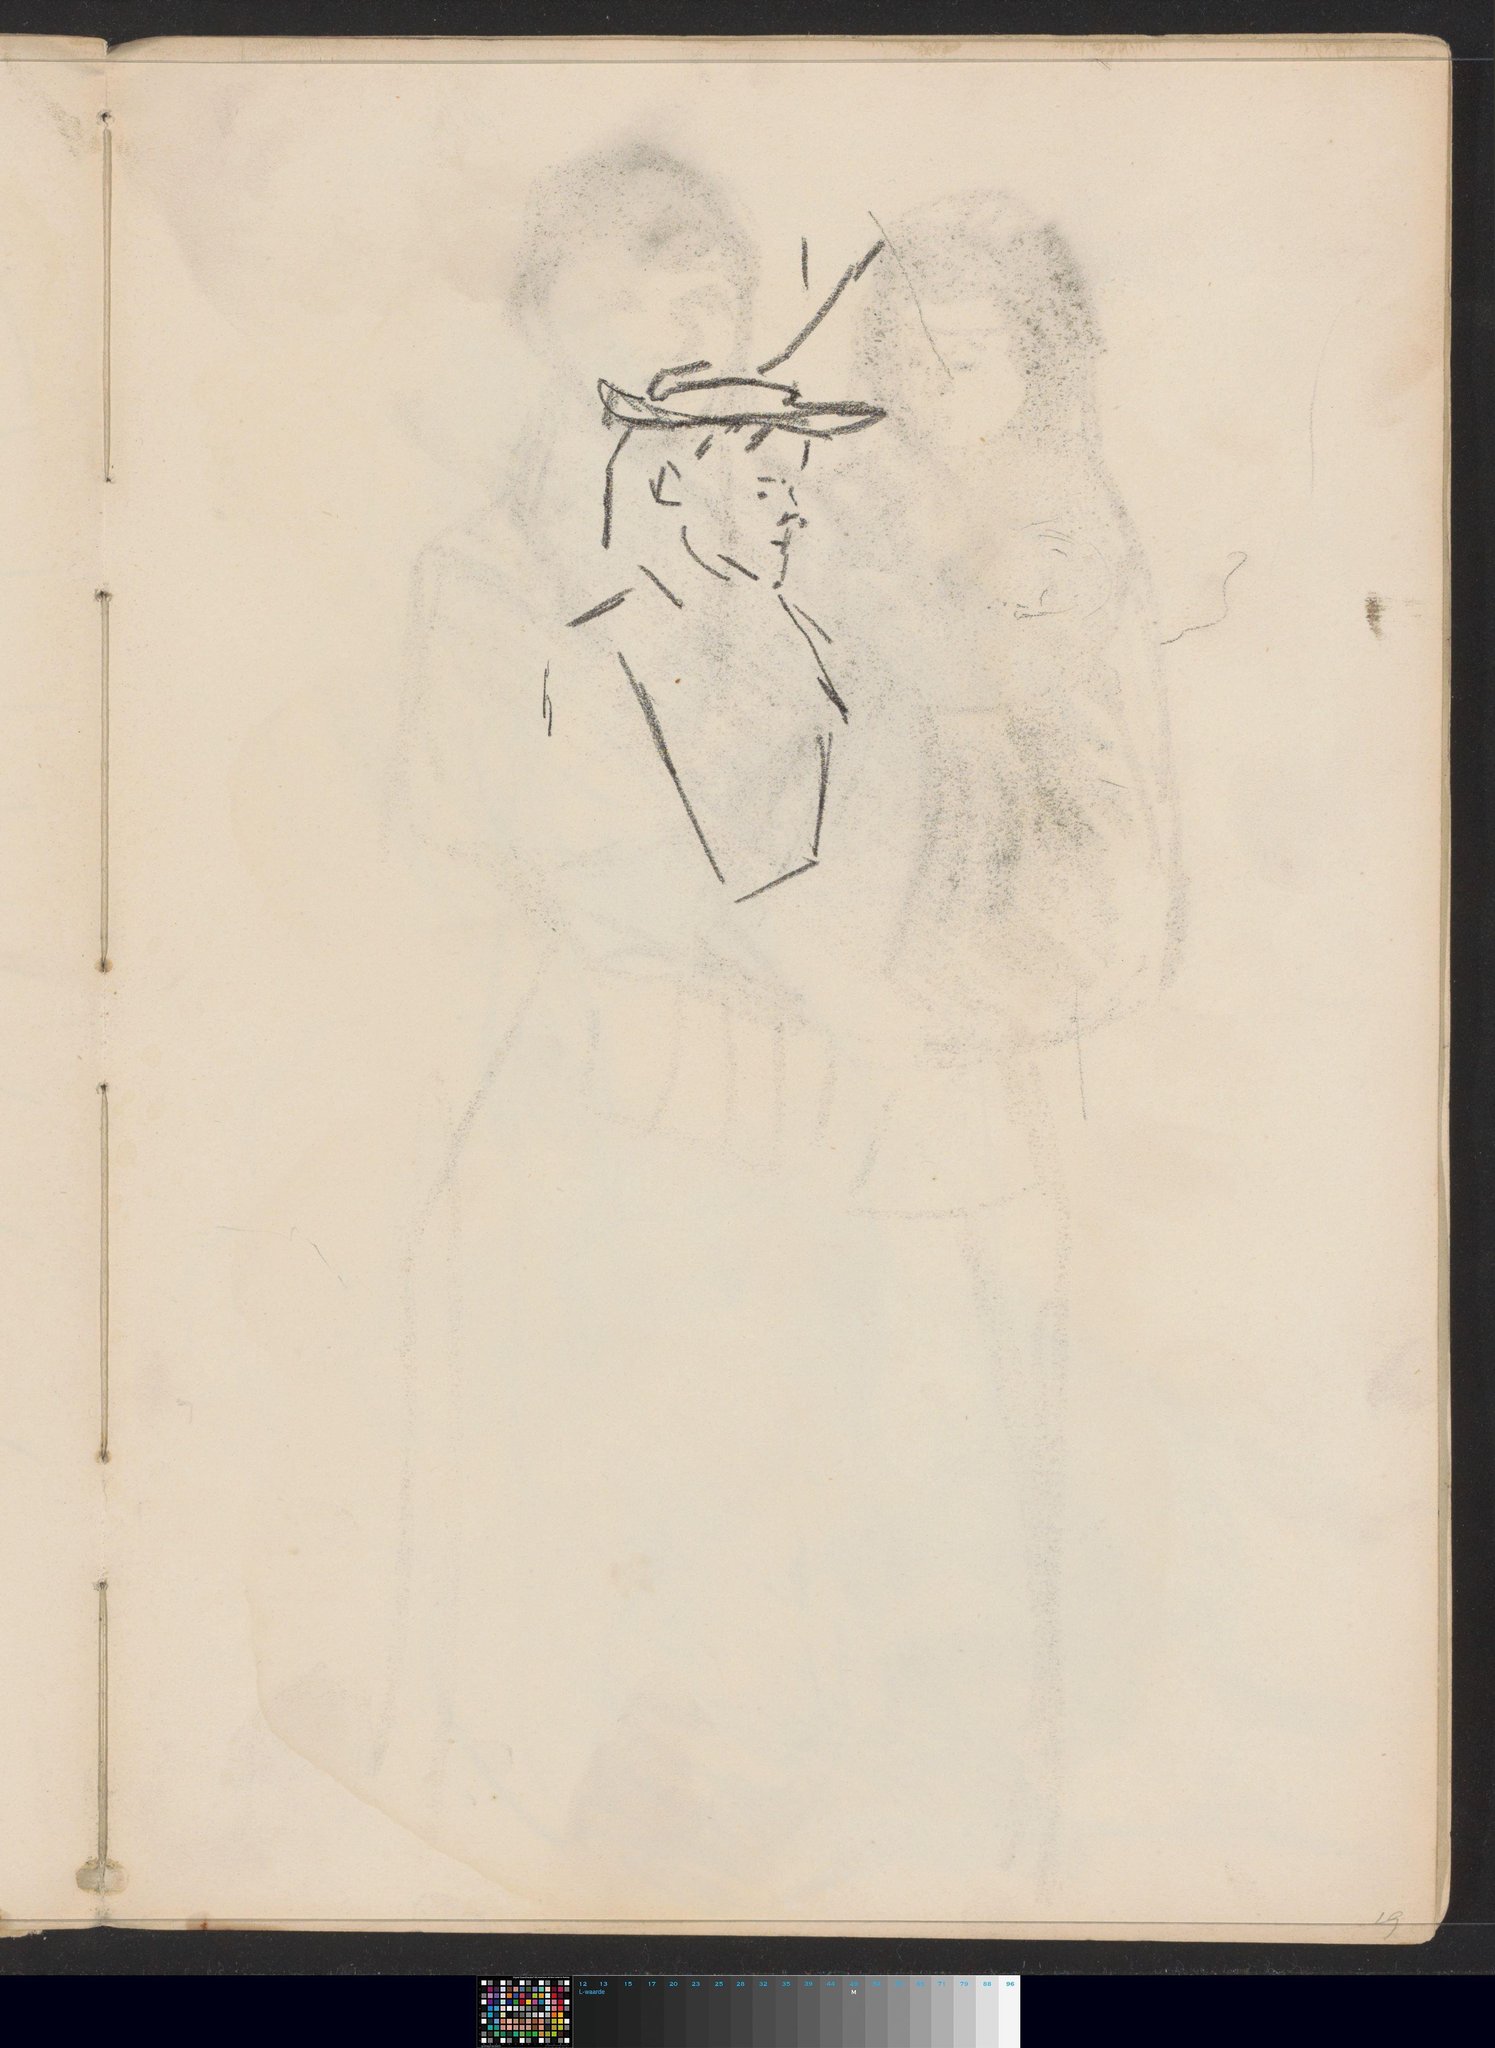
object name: sketchbook leaf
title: Vrouw met hoed, in profiel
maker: isaac israels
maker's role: draughtsman, painter, print maker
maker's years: 1865-1934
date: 1886-1934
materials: chalk, paper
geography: amsterdam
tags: head-gear: hat (+ women's clothes), adult woman (+ sideview, profile)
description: Blad 19 recto uit schetsboek LXVI-B met 25 bladen.